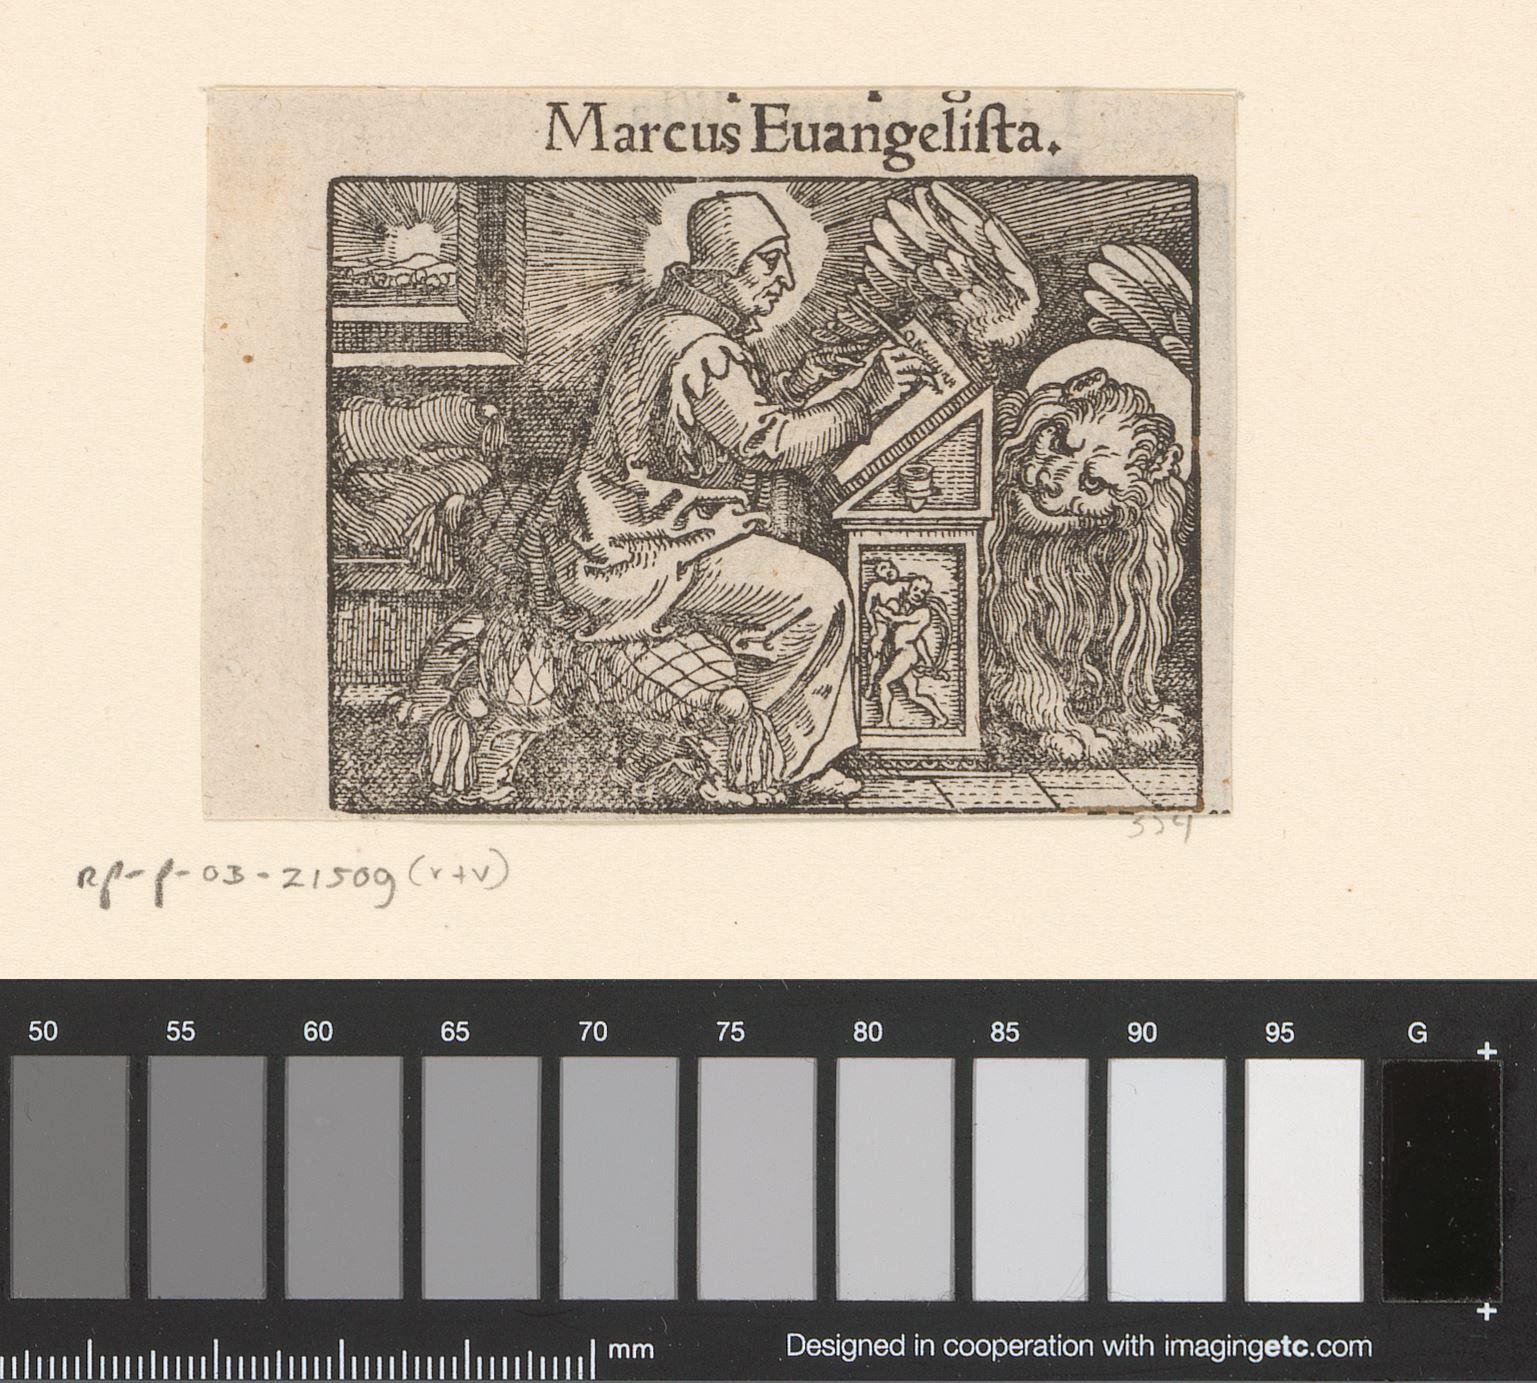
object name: book illustration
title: Marcus Euangelista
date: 1530-1533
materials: paper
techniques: letterpress printing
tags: mark (marcus) the evangelist, and bishop of alexandria; possible attributes: book, (winged) lion, pen and inkhorn, scroll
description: Prent afkomstig uit: Biblicae historiae. Frankfurt am Main: Christian Egenloph, 1539.